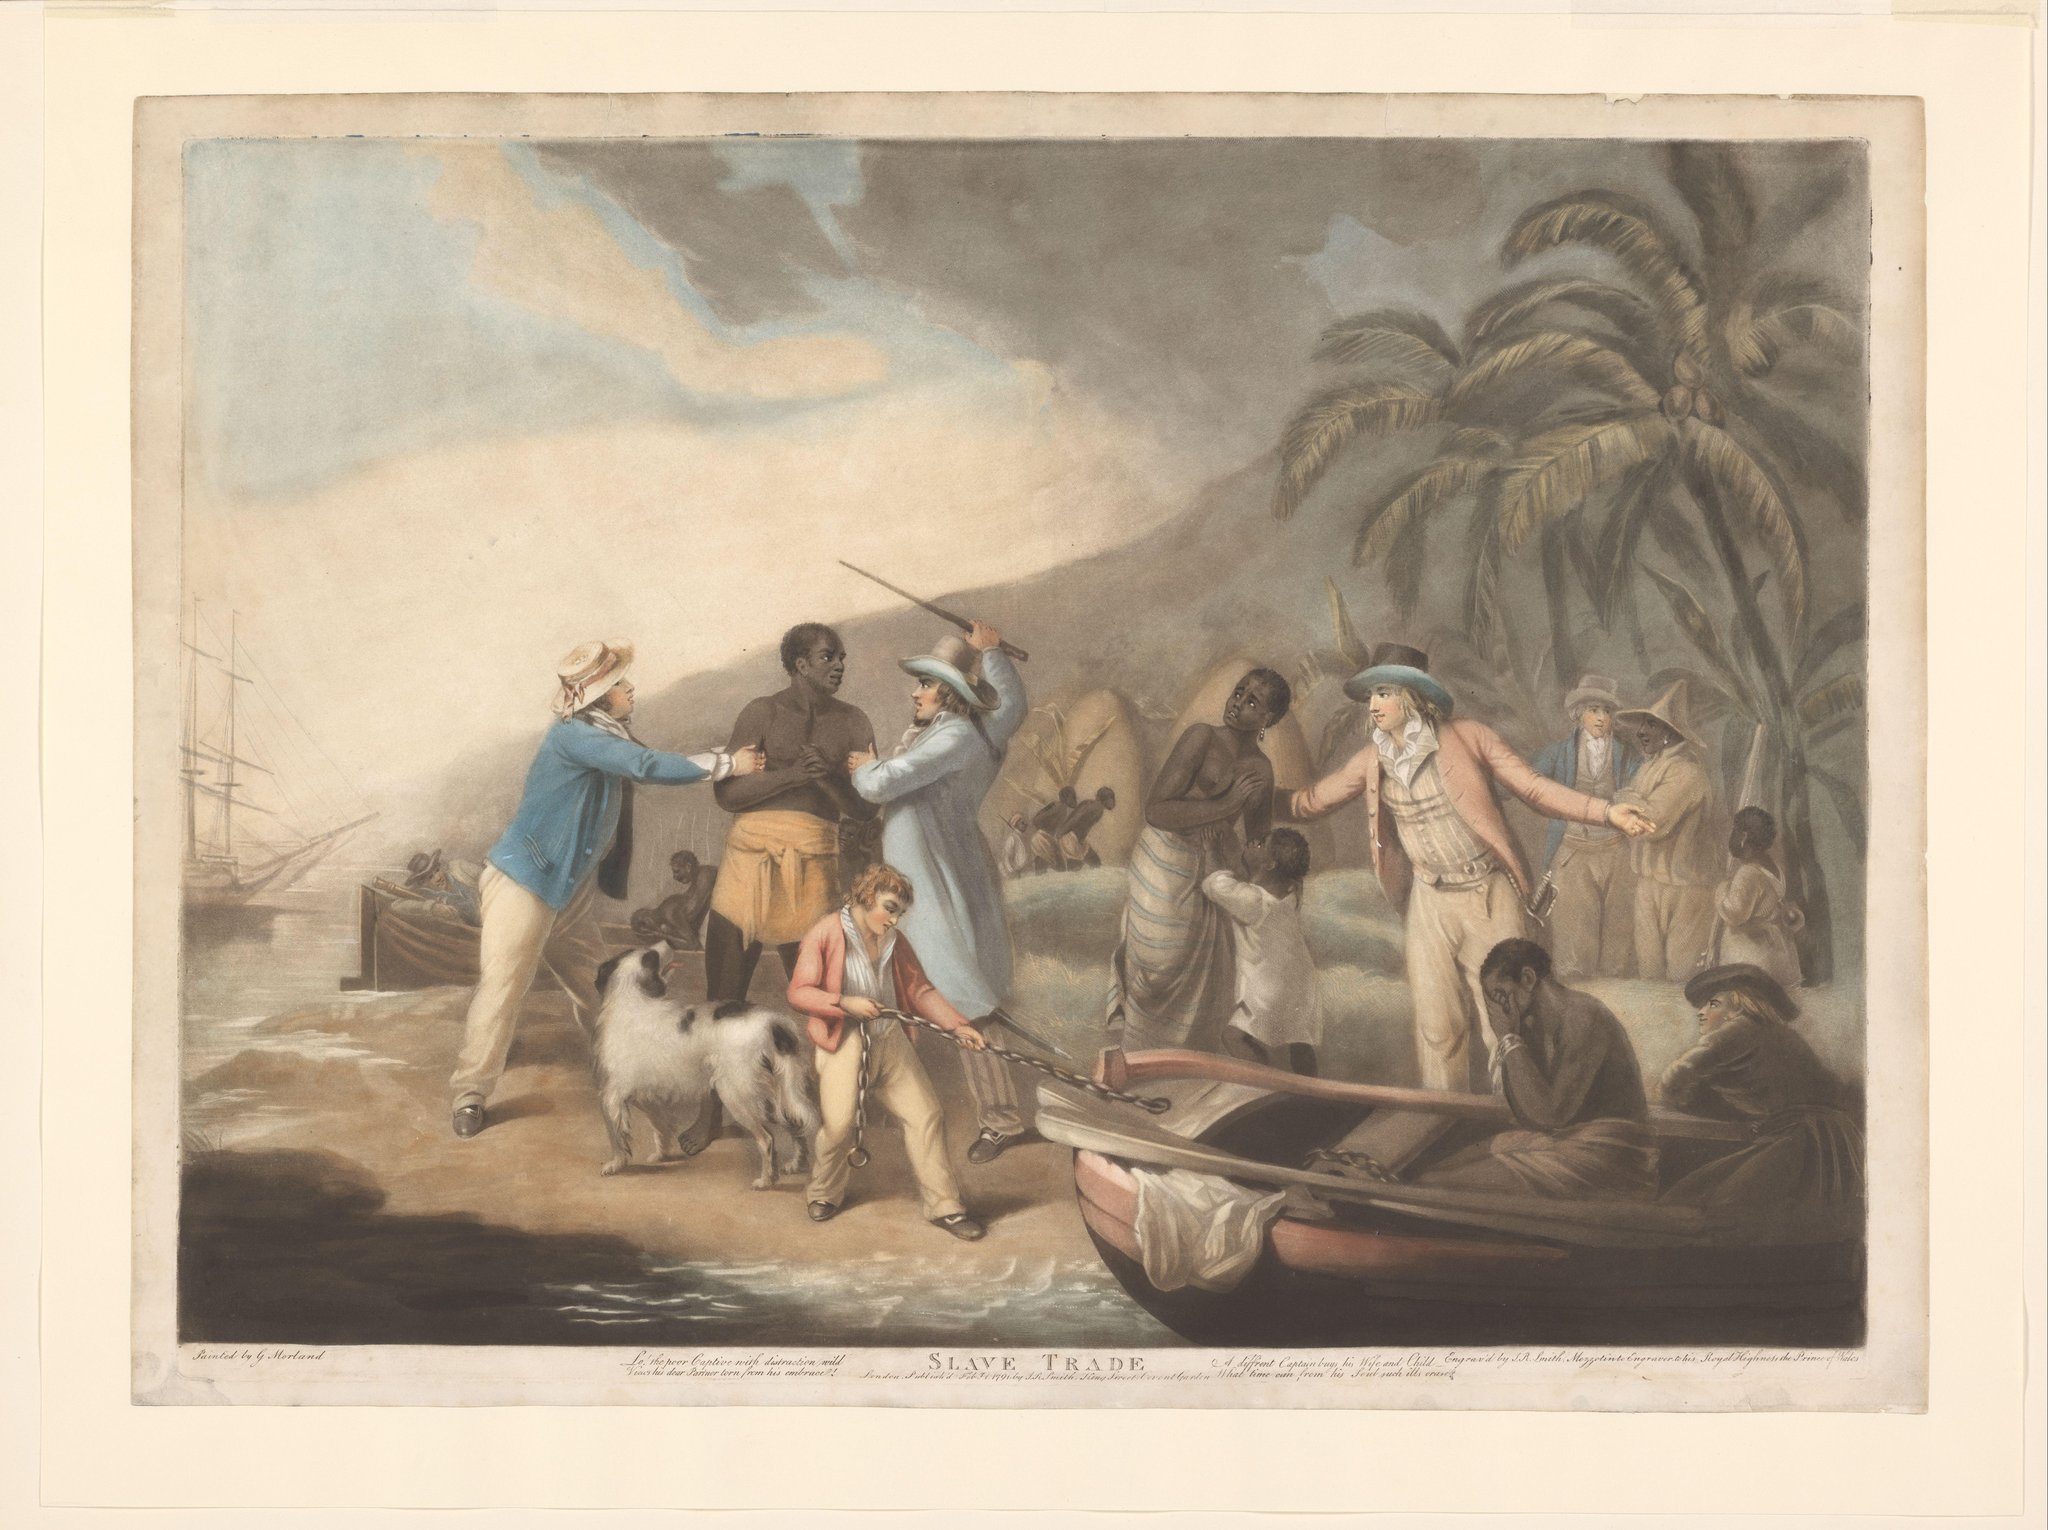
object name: print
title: Afrikaanse familie wordt gescheiden door Europese mannen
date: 1702-1791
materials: paper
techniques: etching, hand coloring, lithography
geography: london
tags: europeans, master ~ enslaved person, slave-trade, africans, rowing-boat, canoe, etc., slavery; serfs and enslaved persons, abolition of slavery, fighting slavery, coast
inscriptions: collector's mark: Lugt 2228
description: Slavenhandel aan de West-Afrikaanse kust. Links slaan twee Europese mannen een Afrikaanse man. Rechts neemt een slavenhandelaar zijn vrouw en kind mee. Rechtsvoor wordt een roeiboot binnengehaald waarin een tot slaaf gemaakte Afrikaanse man zijn handen voor zijn gezicht houdt.